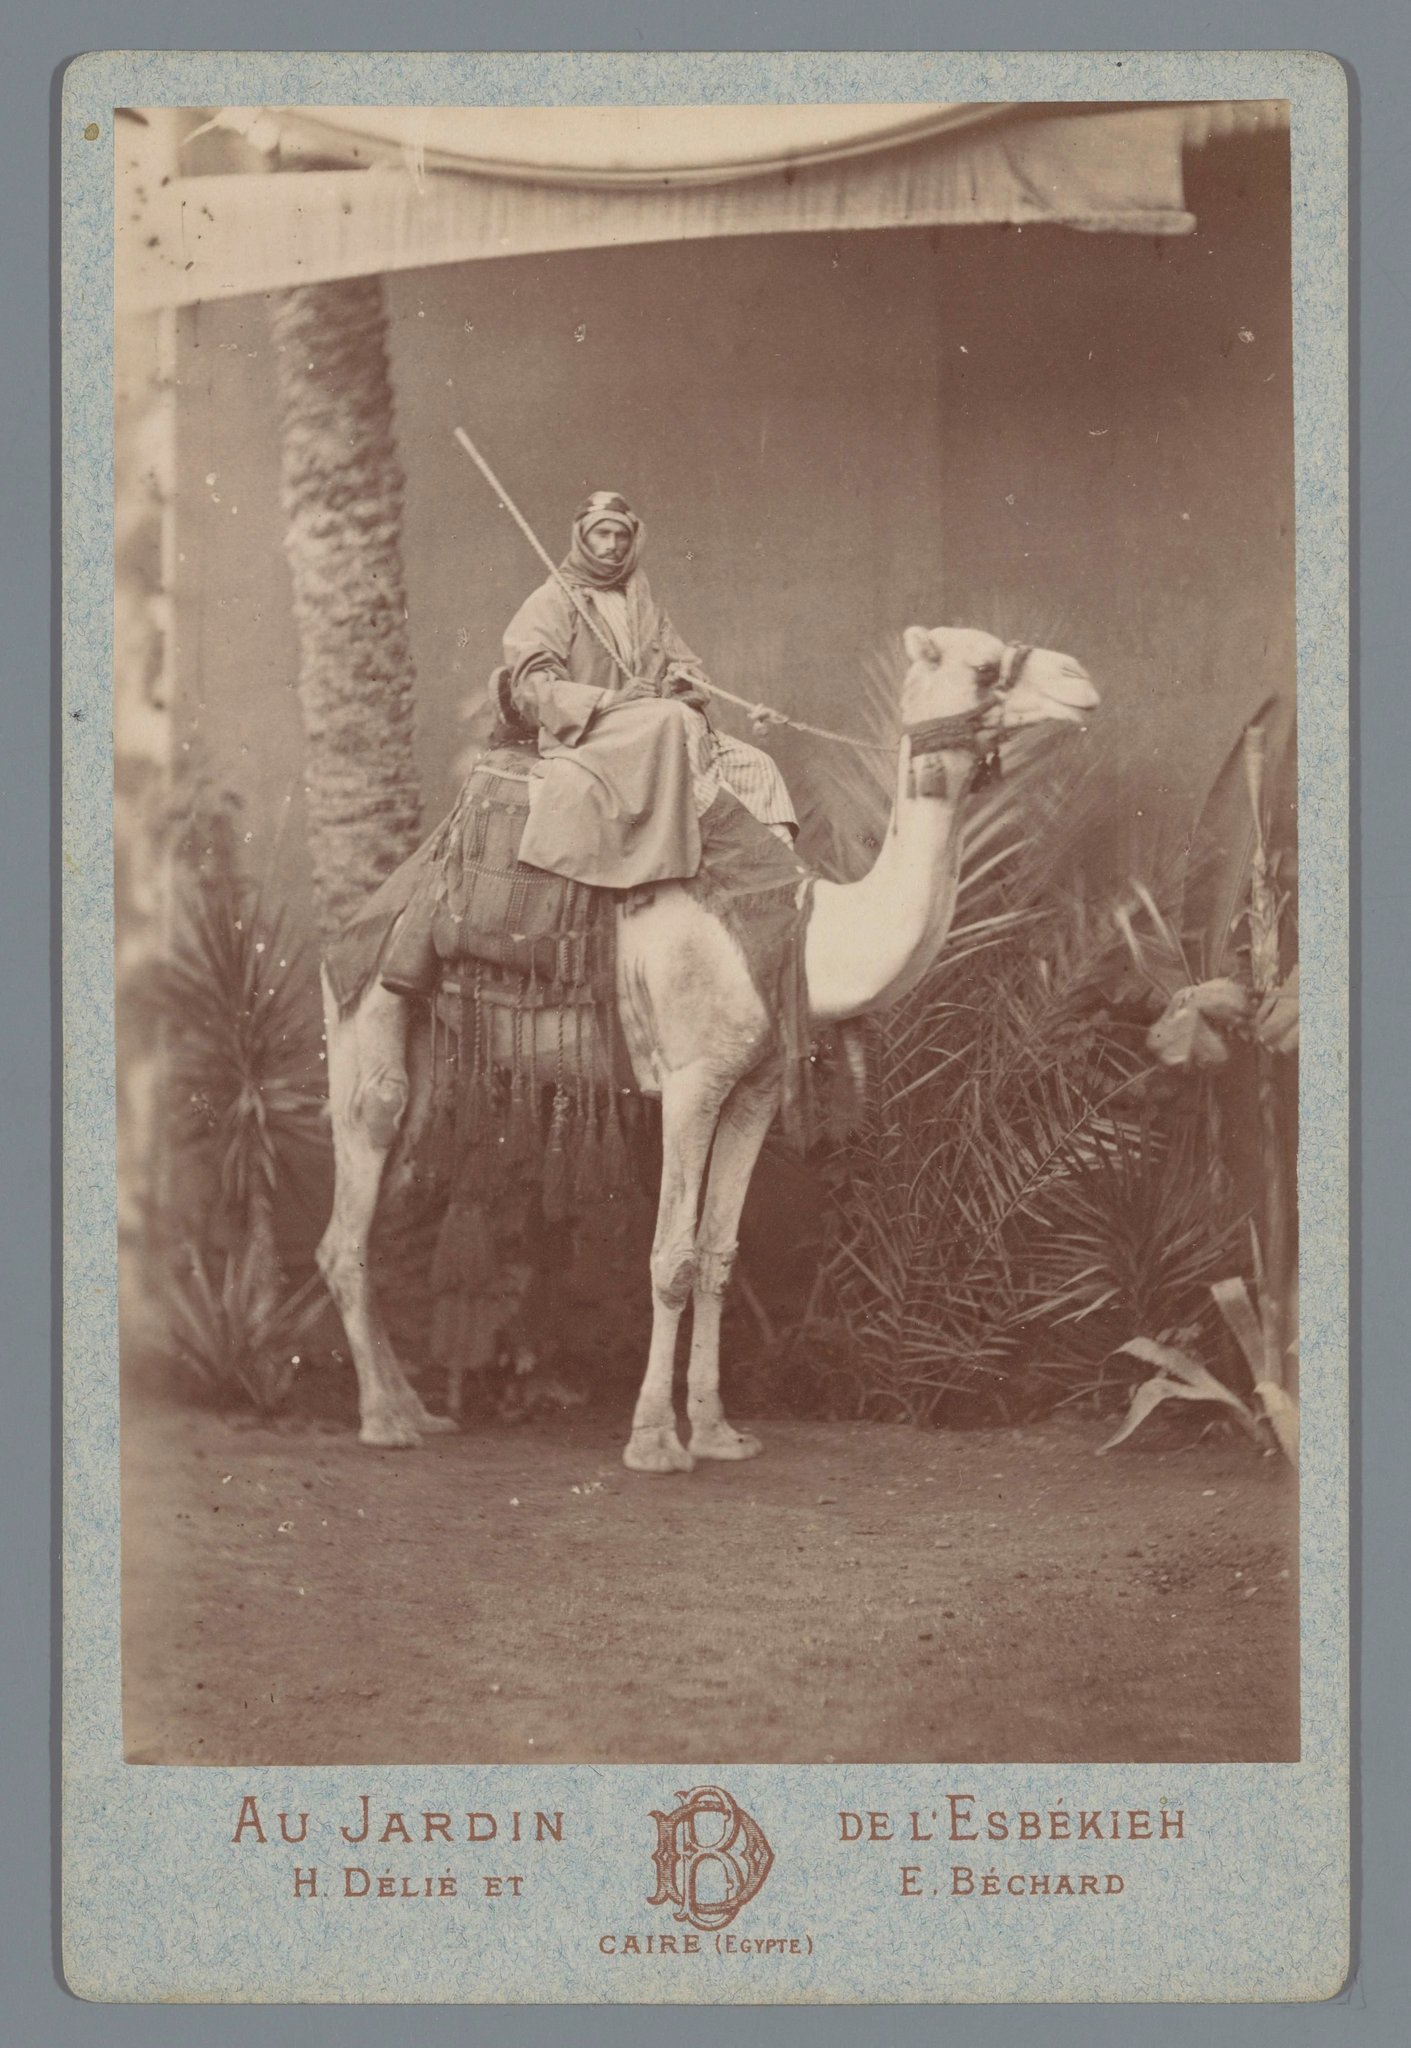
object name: cabinet photograph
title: Man op een kameel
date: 1869-1890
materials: cardboard, photographic support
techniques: albumen print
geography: egypt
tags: hoofed animals: camel, anonymous historical person portrayed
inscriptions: inscription: ‘Au Jardin/ de l'Esbékieh/ H. Délié & E. Béchard/ Caire/ Egypte/ Les Clichés Sont Conservés.’